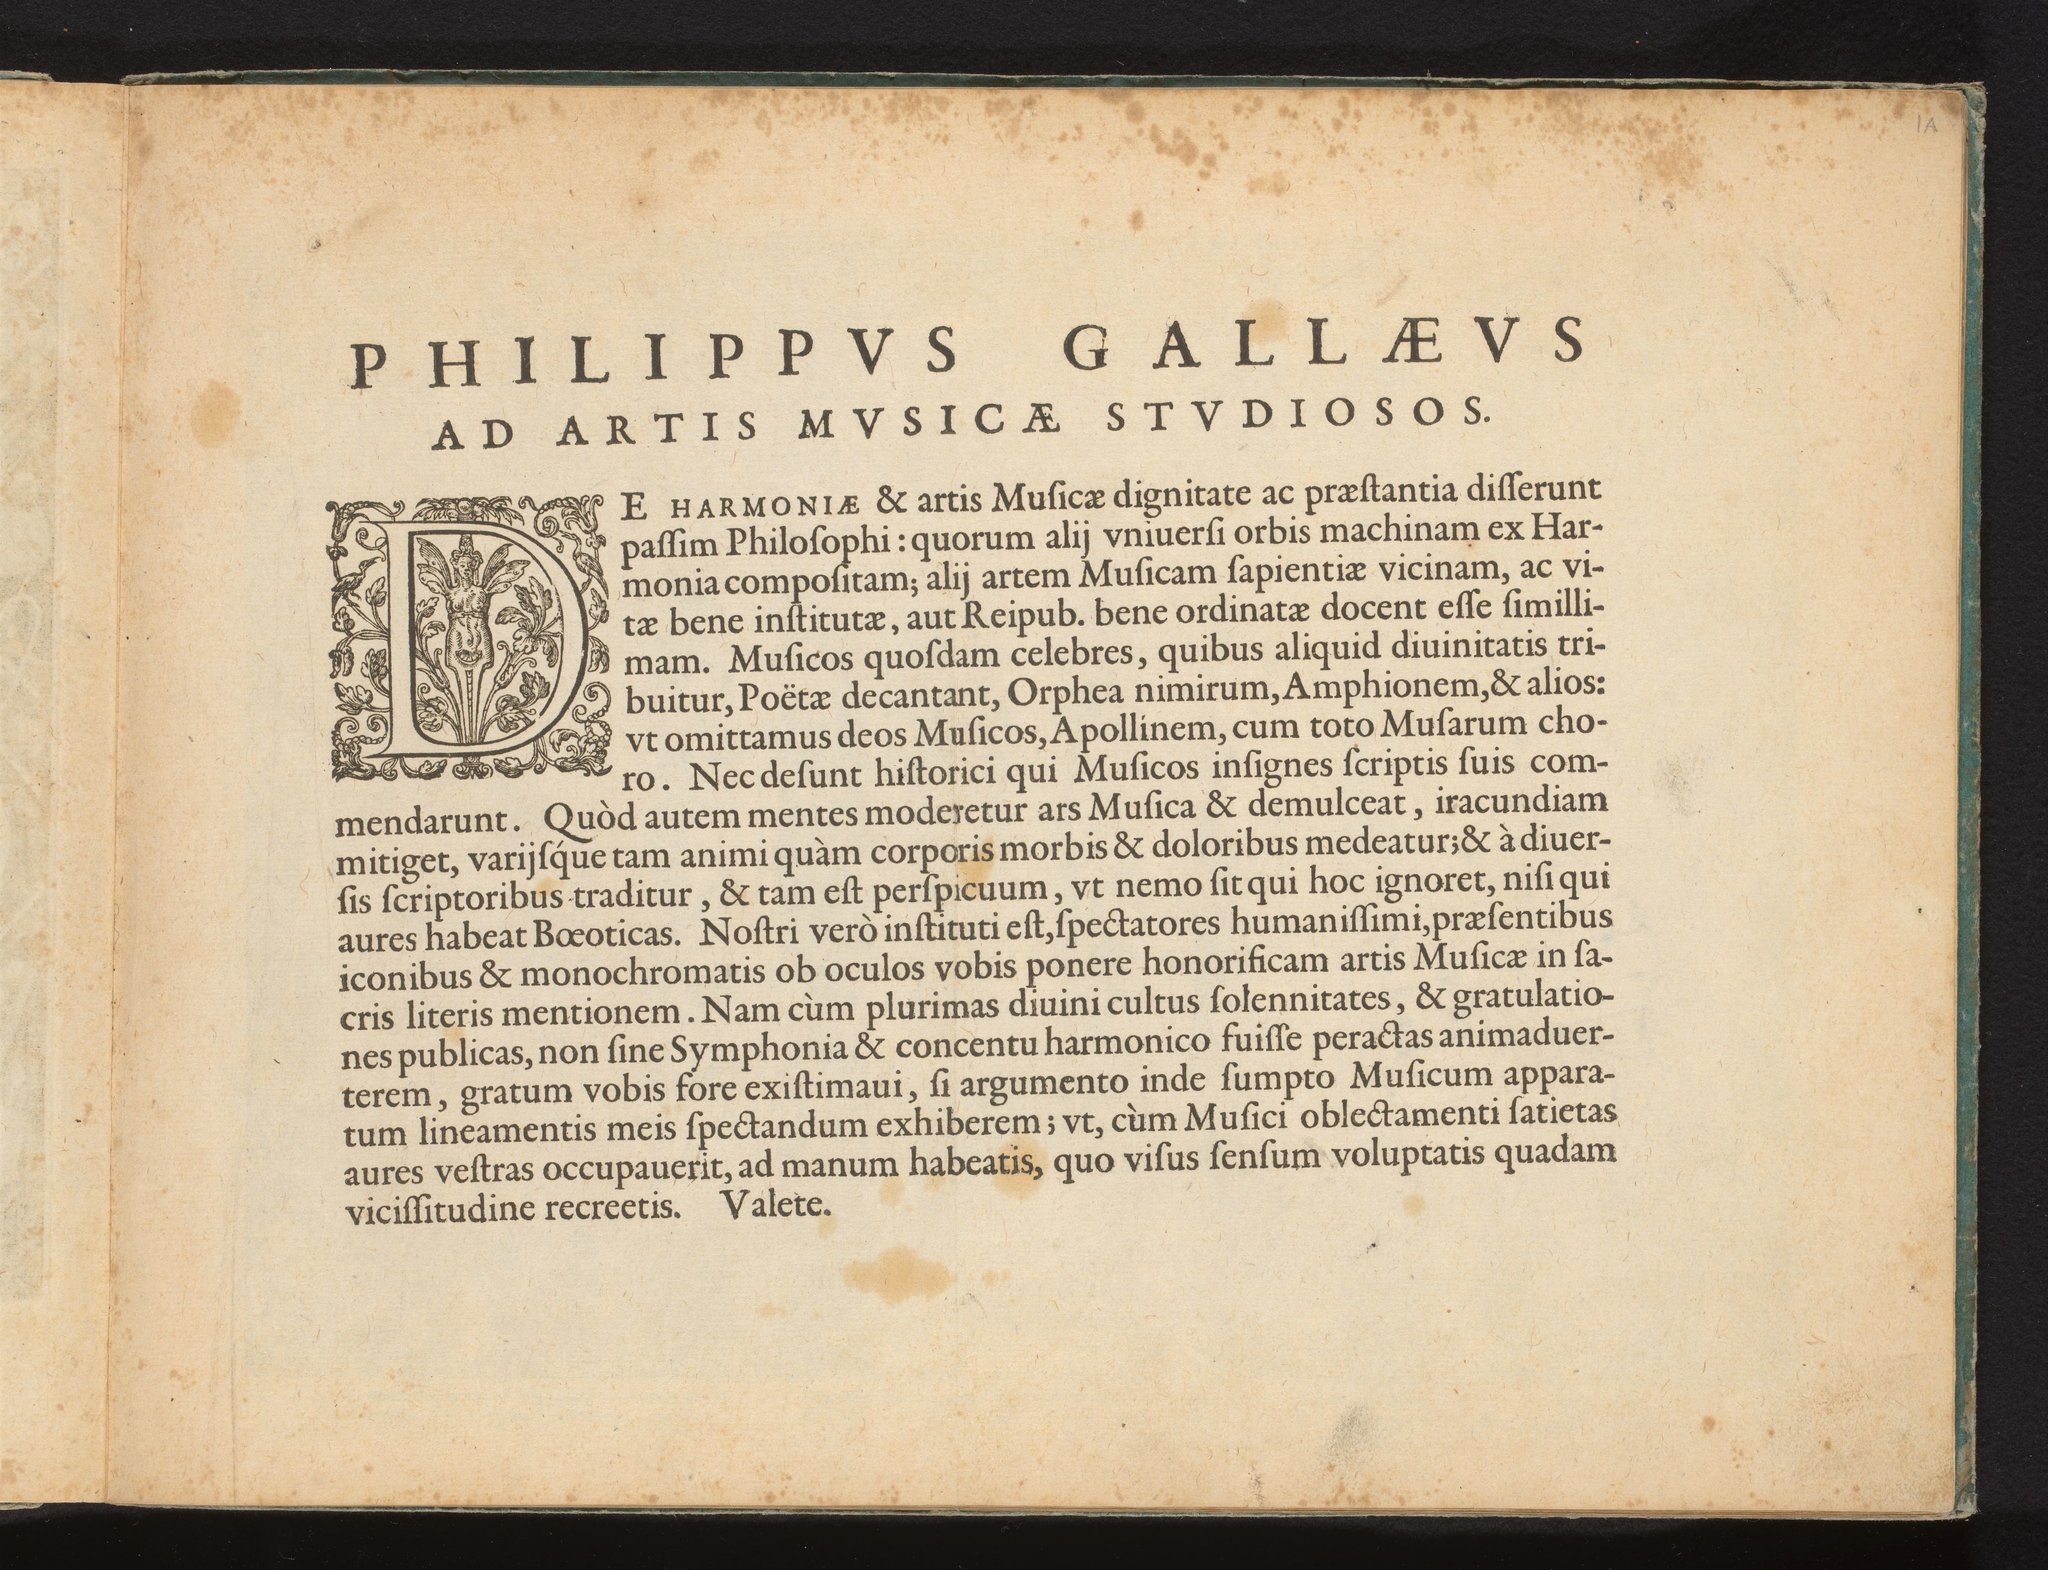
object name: album leaf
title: Encomium musices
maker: philips galle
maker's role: print maker, publisher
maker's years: 1537-1612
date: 1587-1592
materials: paper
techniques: letterpress printing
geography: antwerp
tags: initial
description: Inleiding van de uitgever bij de prentserie getiteld Encomium musices over de harmonie en de kunst van de muziek. De tekst begint met een grote initiaal D. De inleiding maakt deel uit van een album.